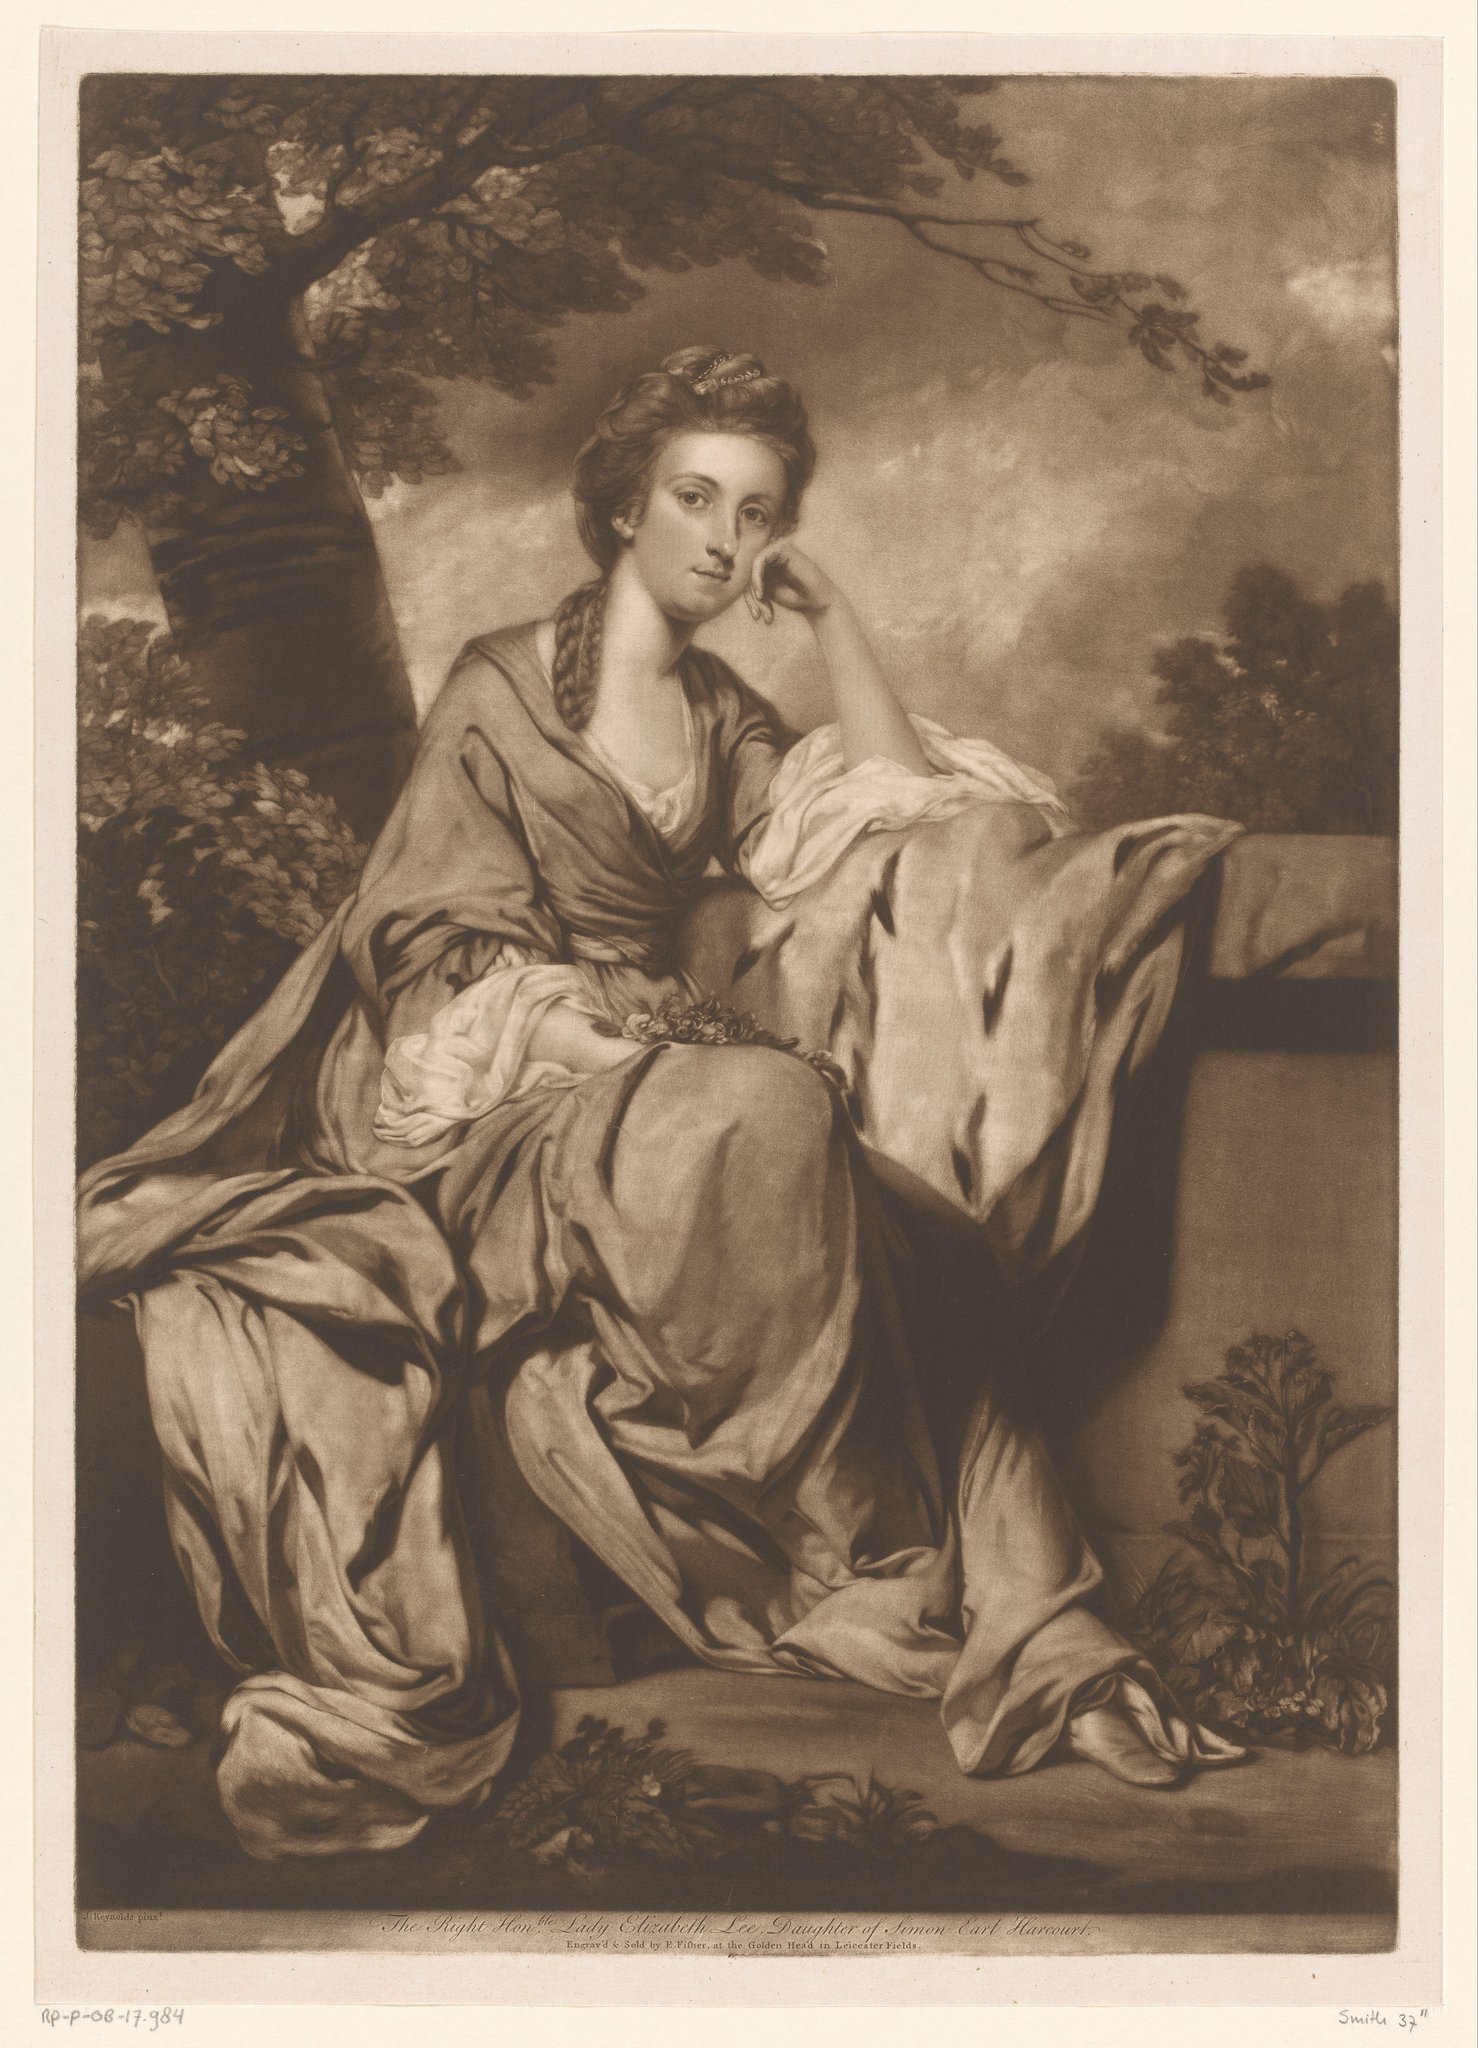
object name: print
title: The Right Honble. Lady Elizabeth Lee, Daughter of Simon Earl Harcourt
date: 1765-1770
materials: paper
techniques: mezzotint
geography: london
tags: historical persons - bb - woman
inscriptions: collector's mark: Lugt 240